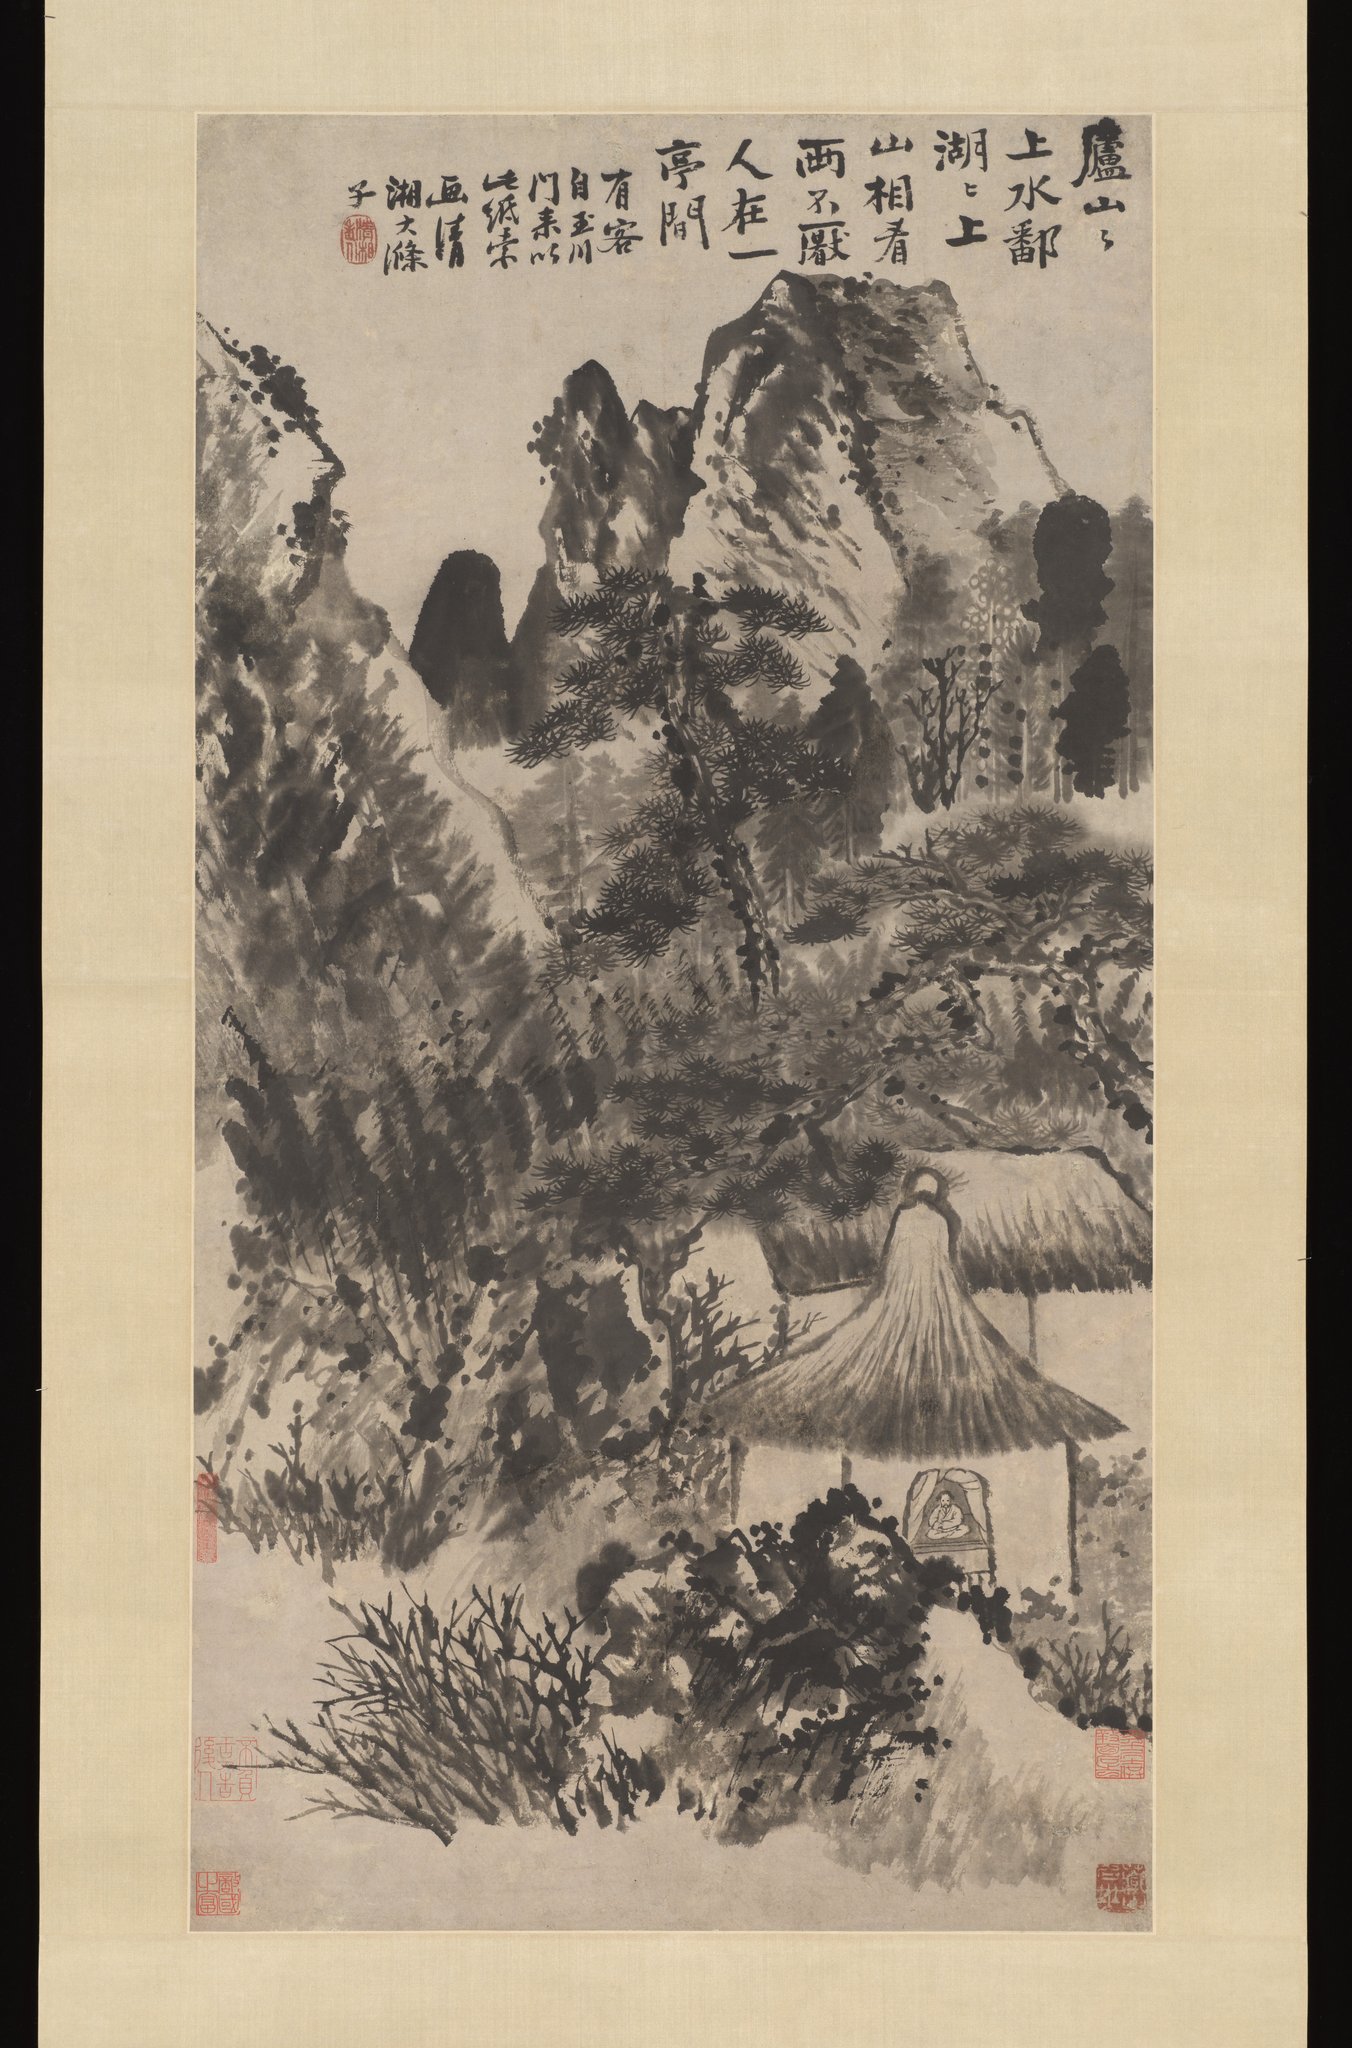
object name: hanging scroll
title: Hermitage in Mount Lu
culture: chinese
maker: shitao (zhu ruoji)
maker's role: artist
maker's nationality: chinese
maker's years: 1642-1707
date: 1644-1707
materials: ink, paper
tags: mountains,landscapes